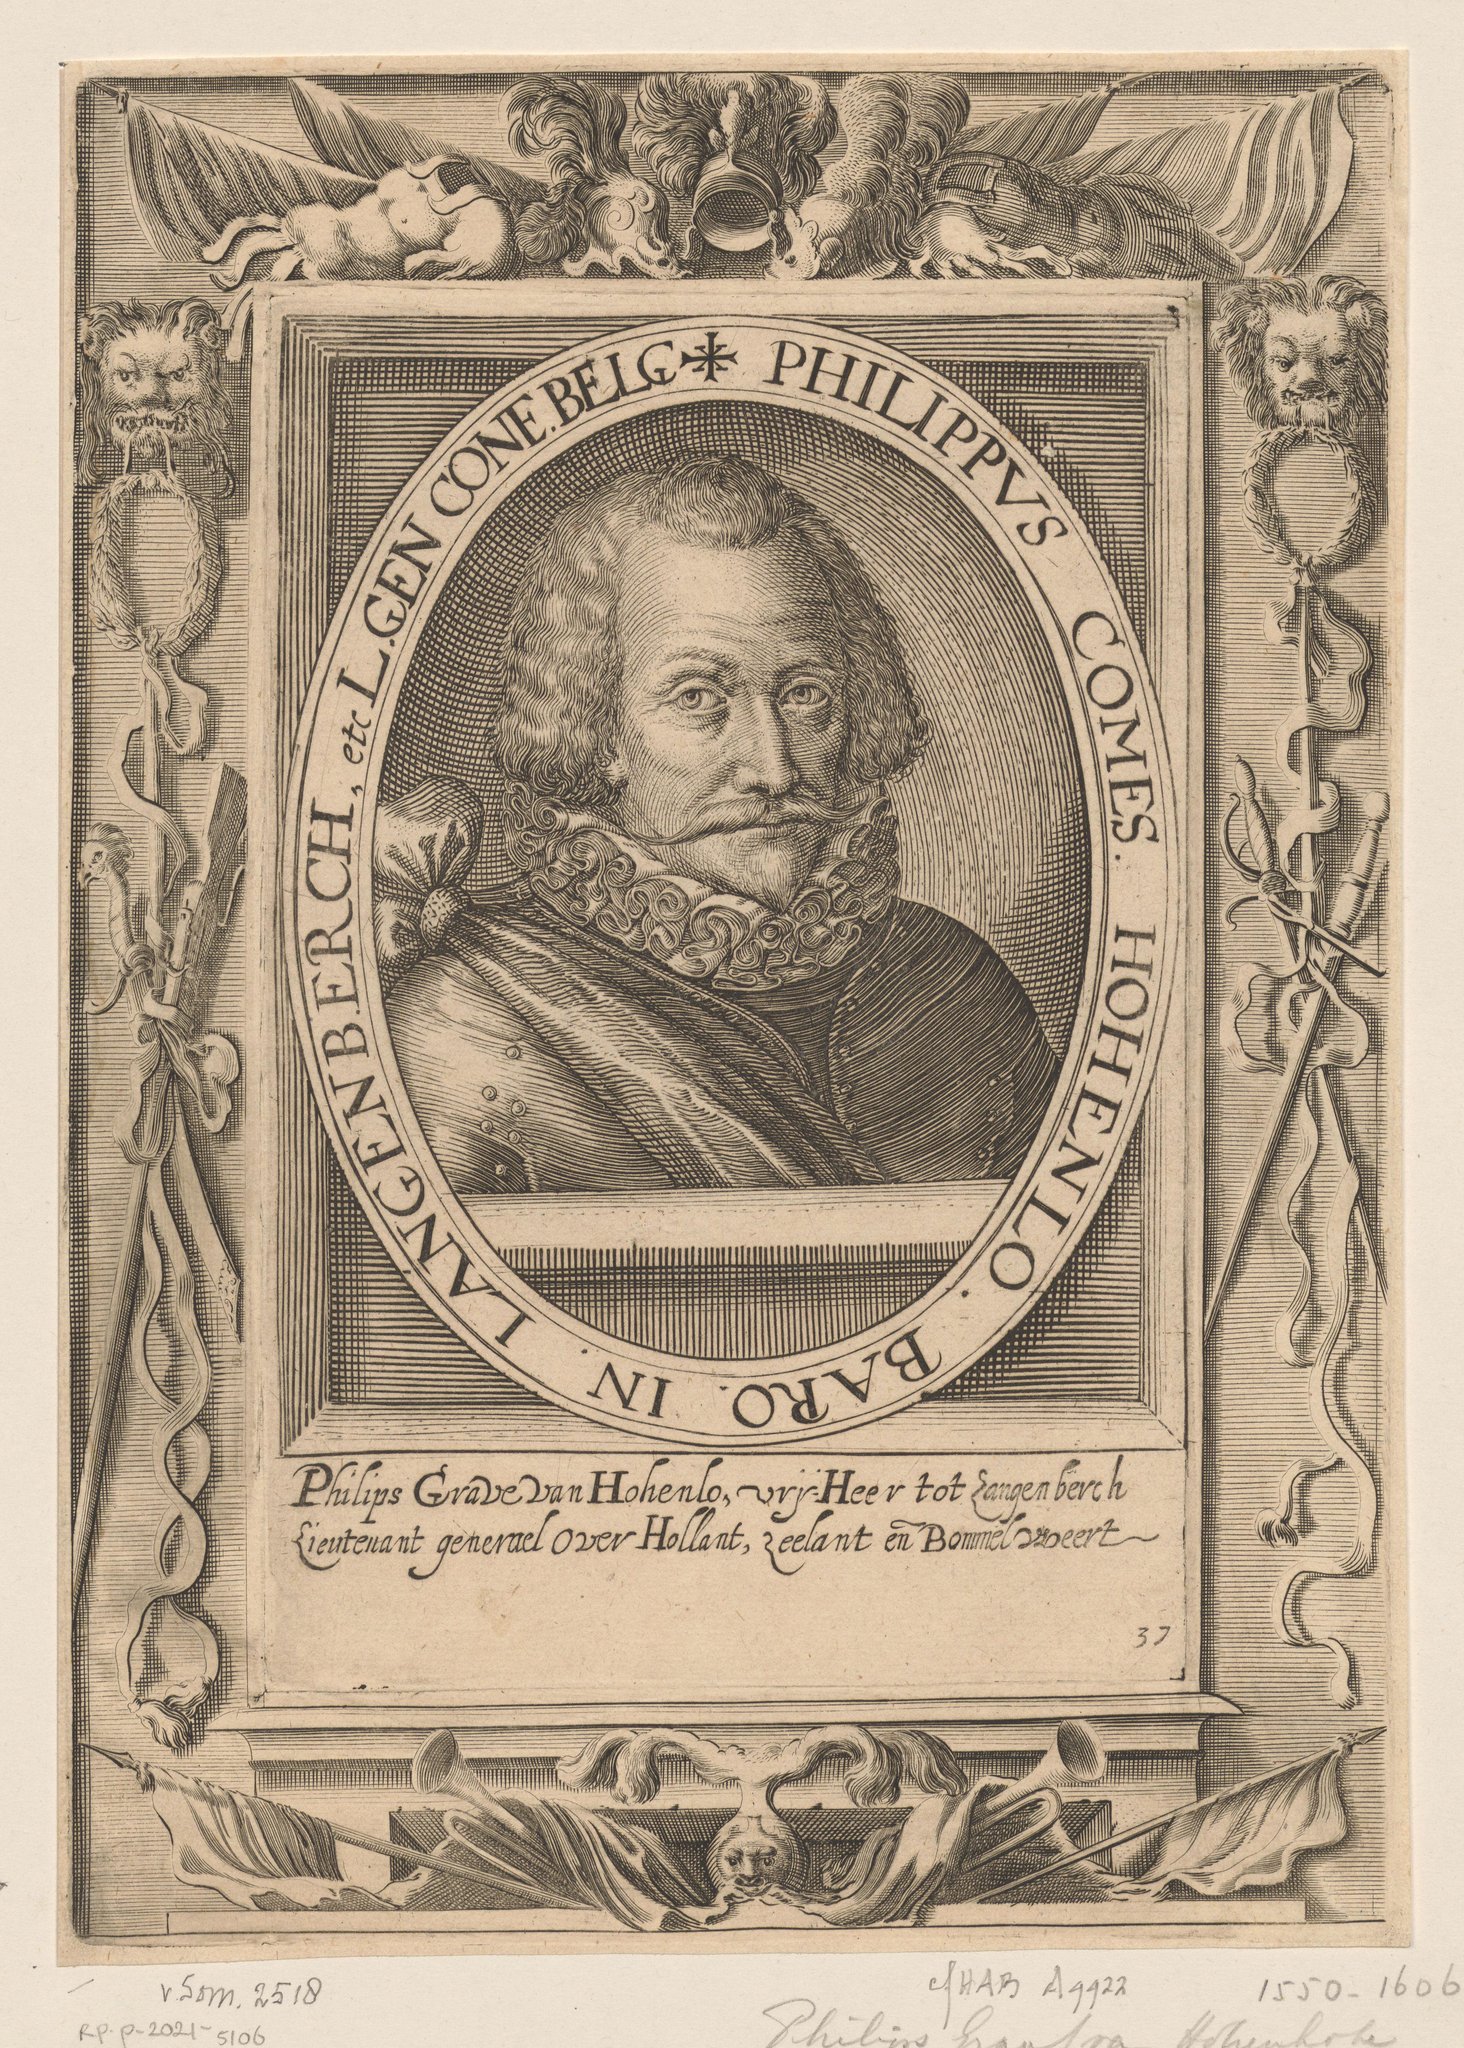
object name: print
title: Portret van Filips, graaf van Hohenlohe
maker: Anonymous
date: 1600-1675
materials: paper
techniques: engraving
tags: trophy, i.e.: decorative arrangement of symbolic or typical objects ~ ornament, moustache, adult man, historical persons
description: Prent gebruikt in meerdere edities en vertalingen van Emanuel van Meterens 'Nederlantsche historien'.